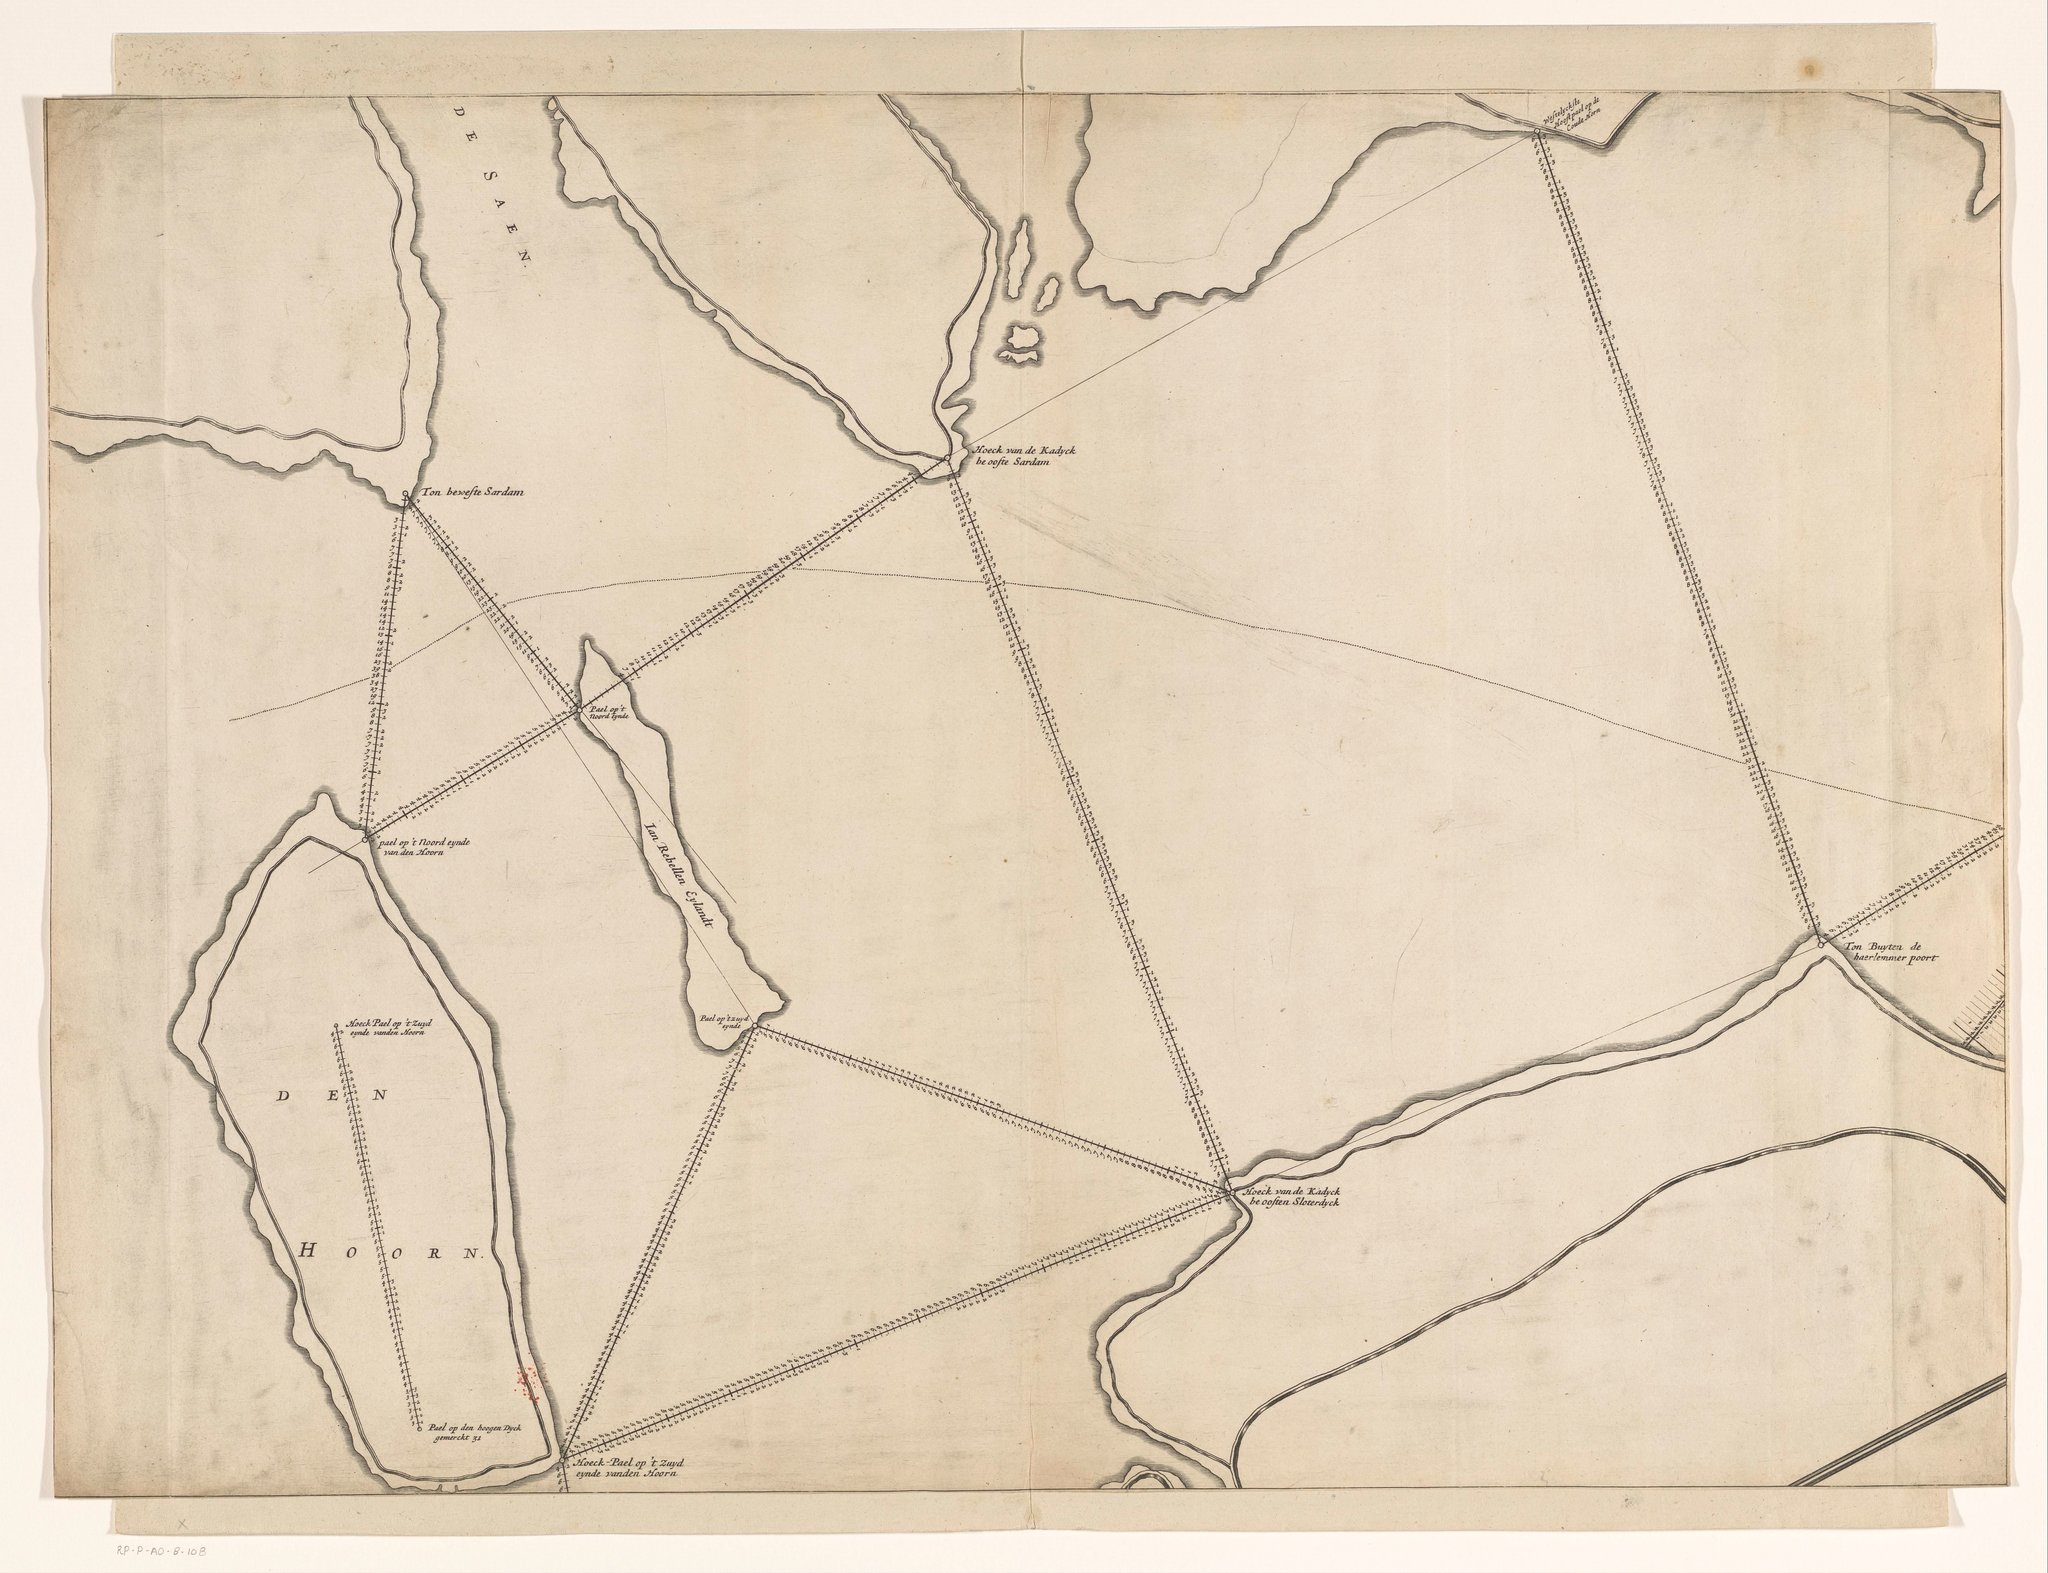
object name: print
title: Kaart van het IJ, 1674 (linkerdeel)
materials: paper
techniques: engraving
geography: amsterdam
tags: maps of separate countries or regions, river, amsterdam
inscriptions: collector's mark: Lugt 195